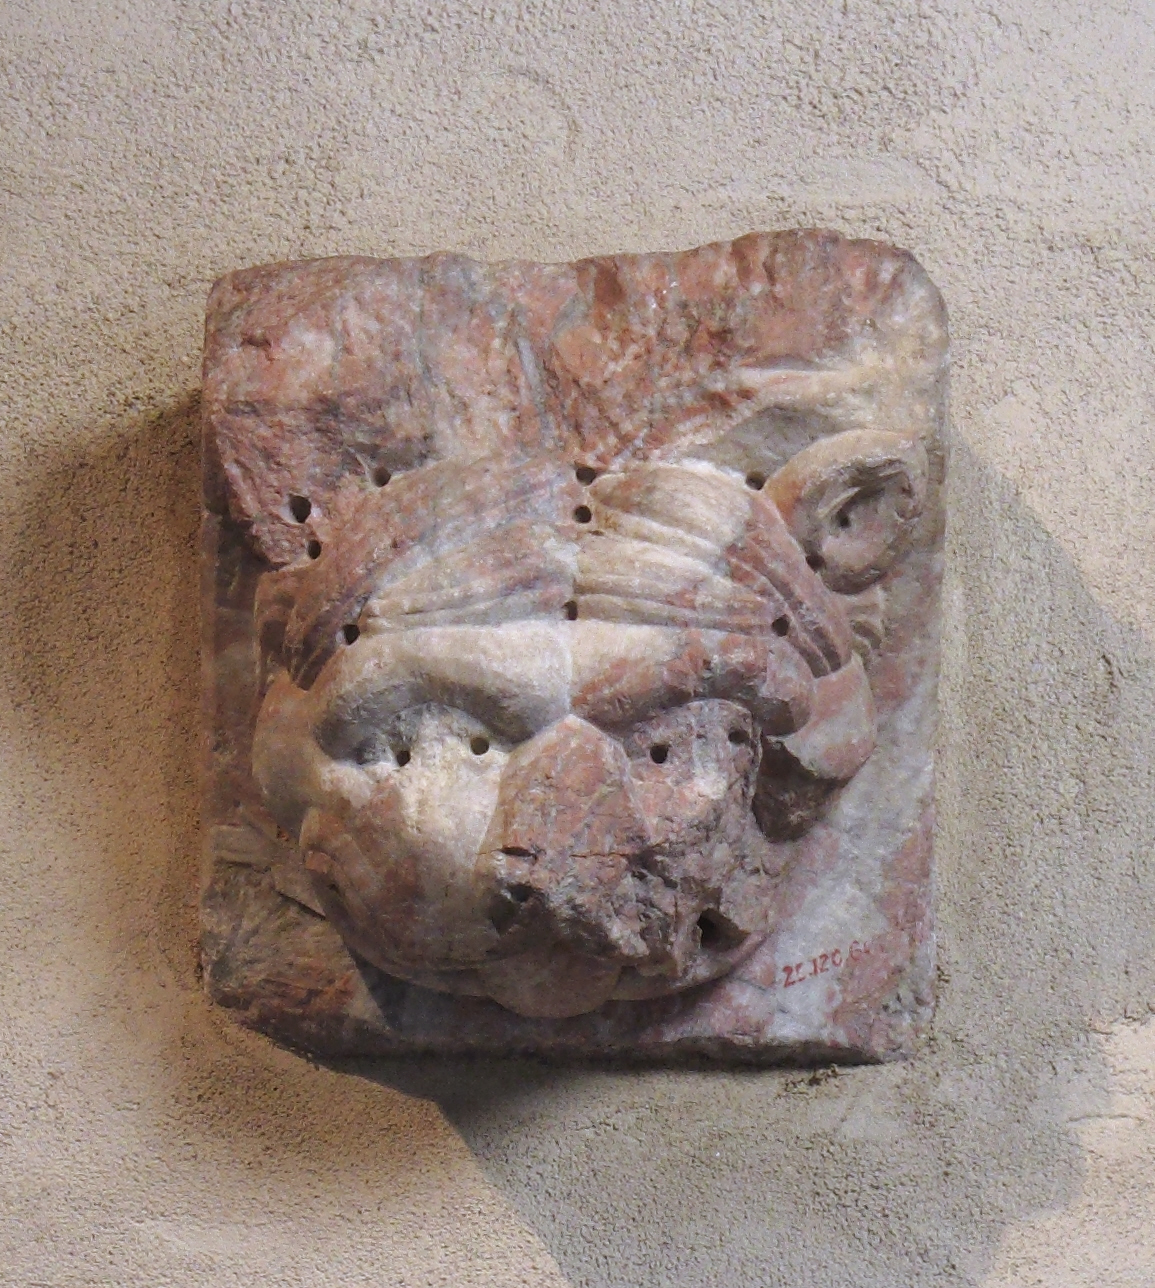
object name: corbel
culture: catalan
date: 1130-1140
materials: marble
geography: france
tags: animals